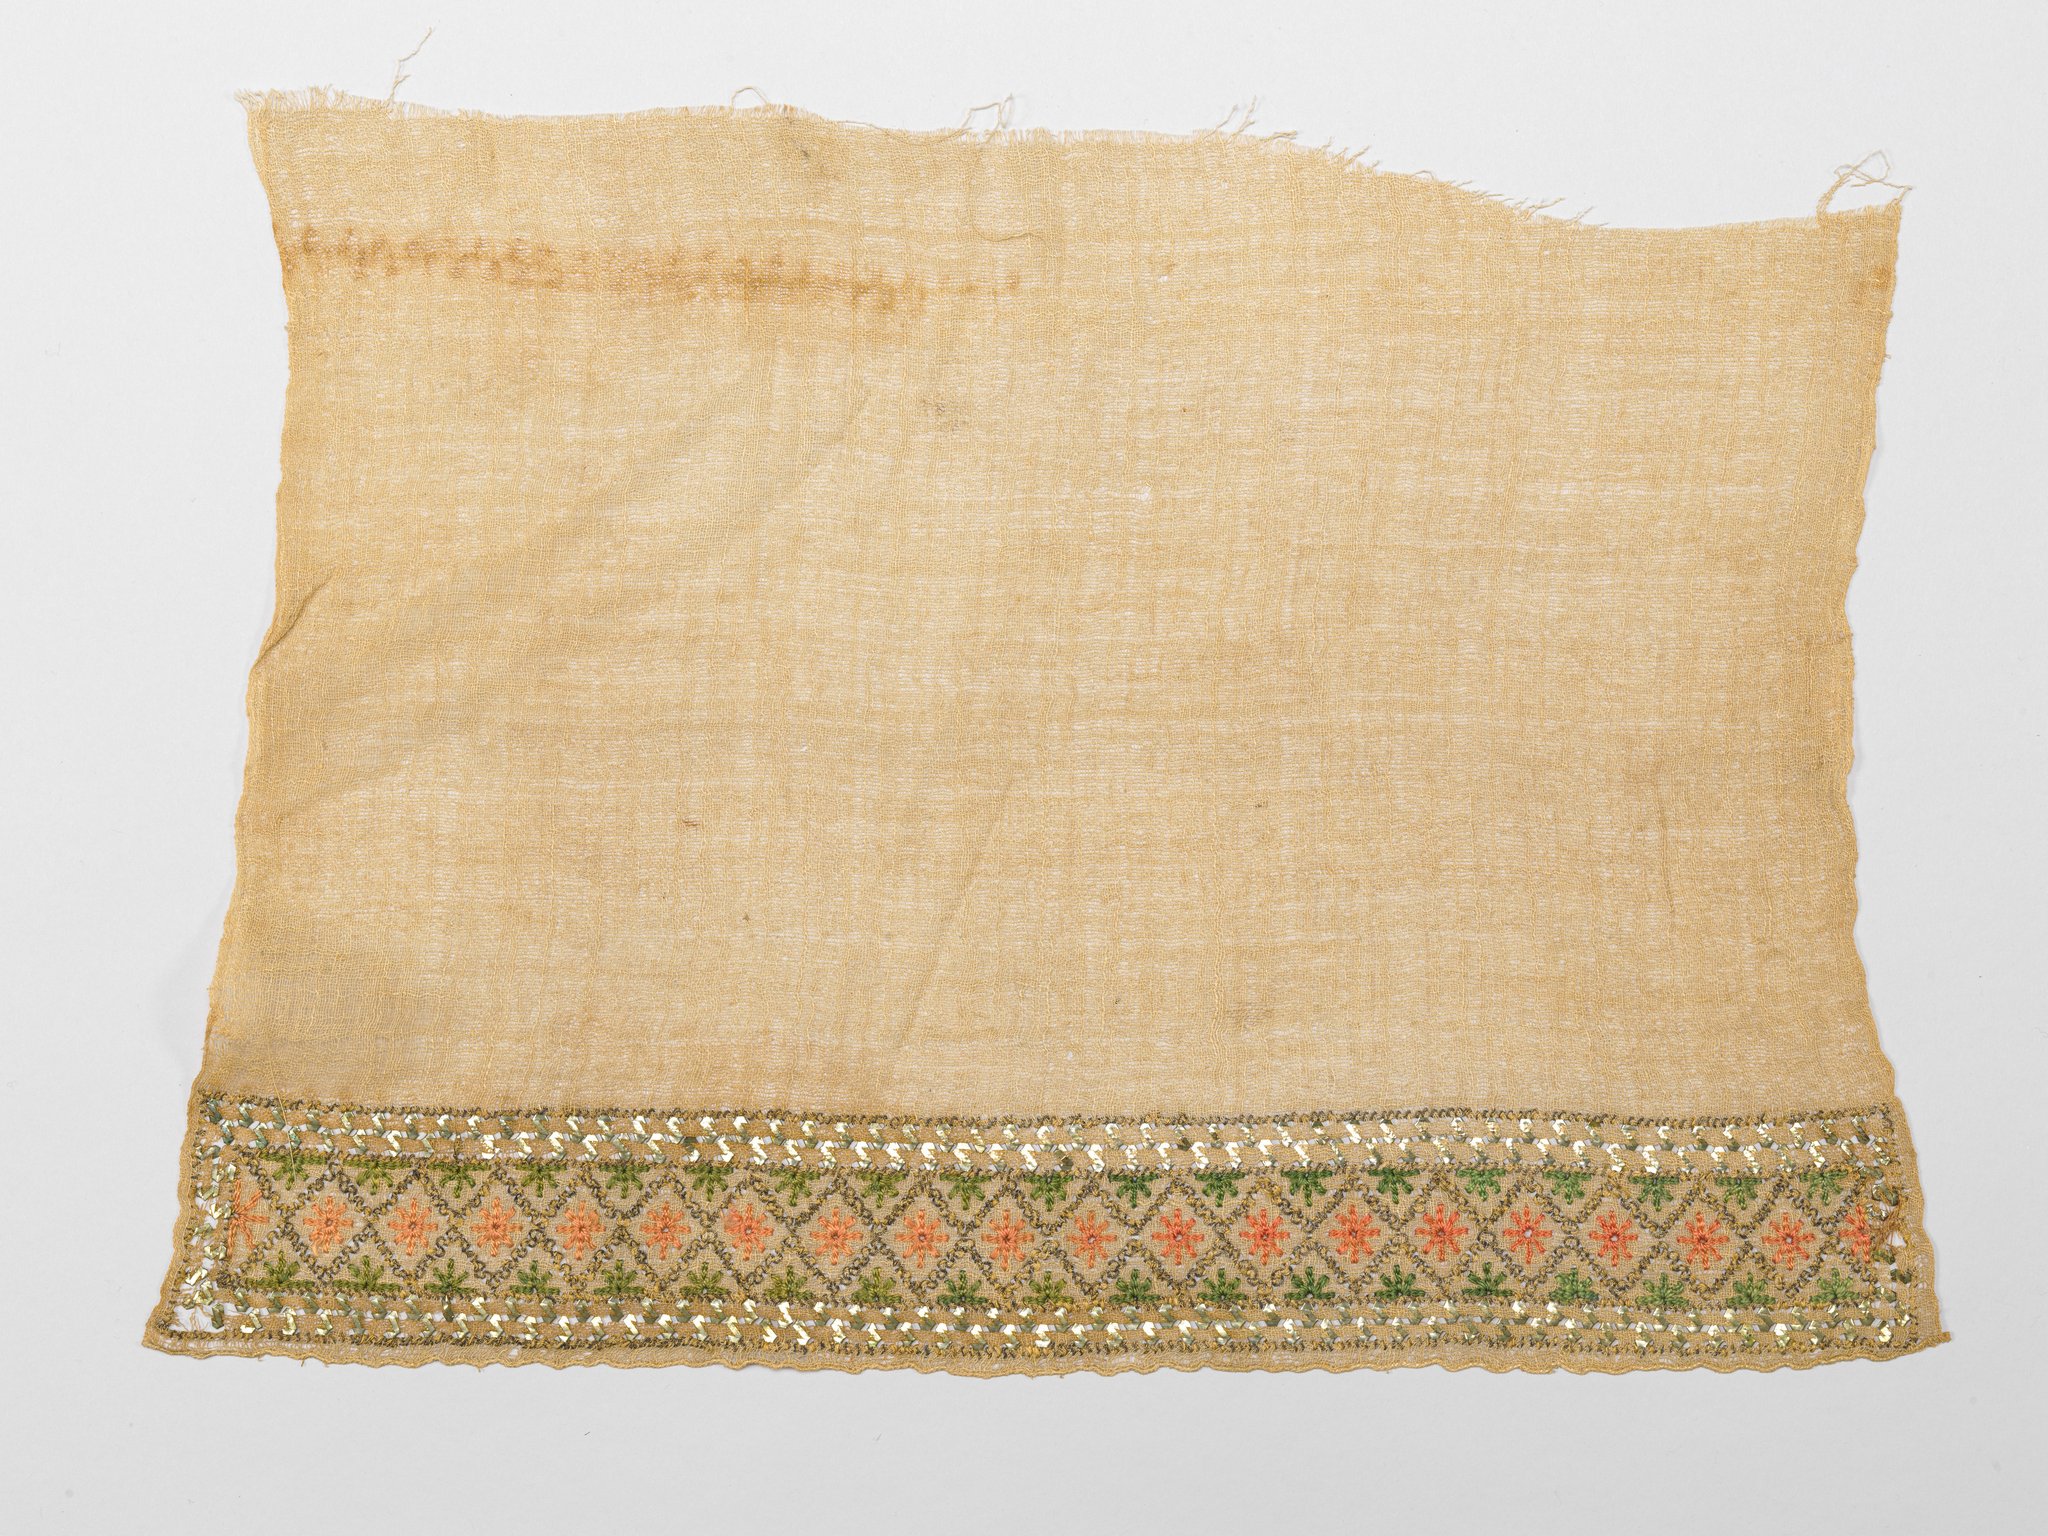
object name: towel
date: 1801-1900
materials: linen, silk, thread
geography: turkey